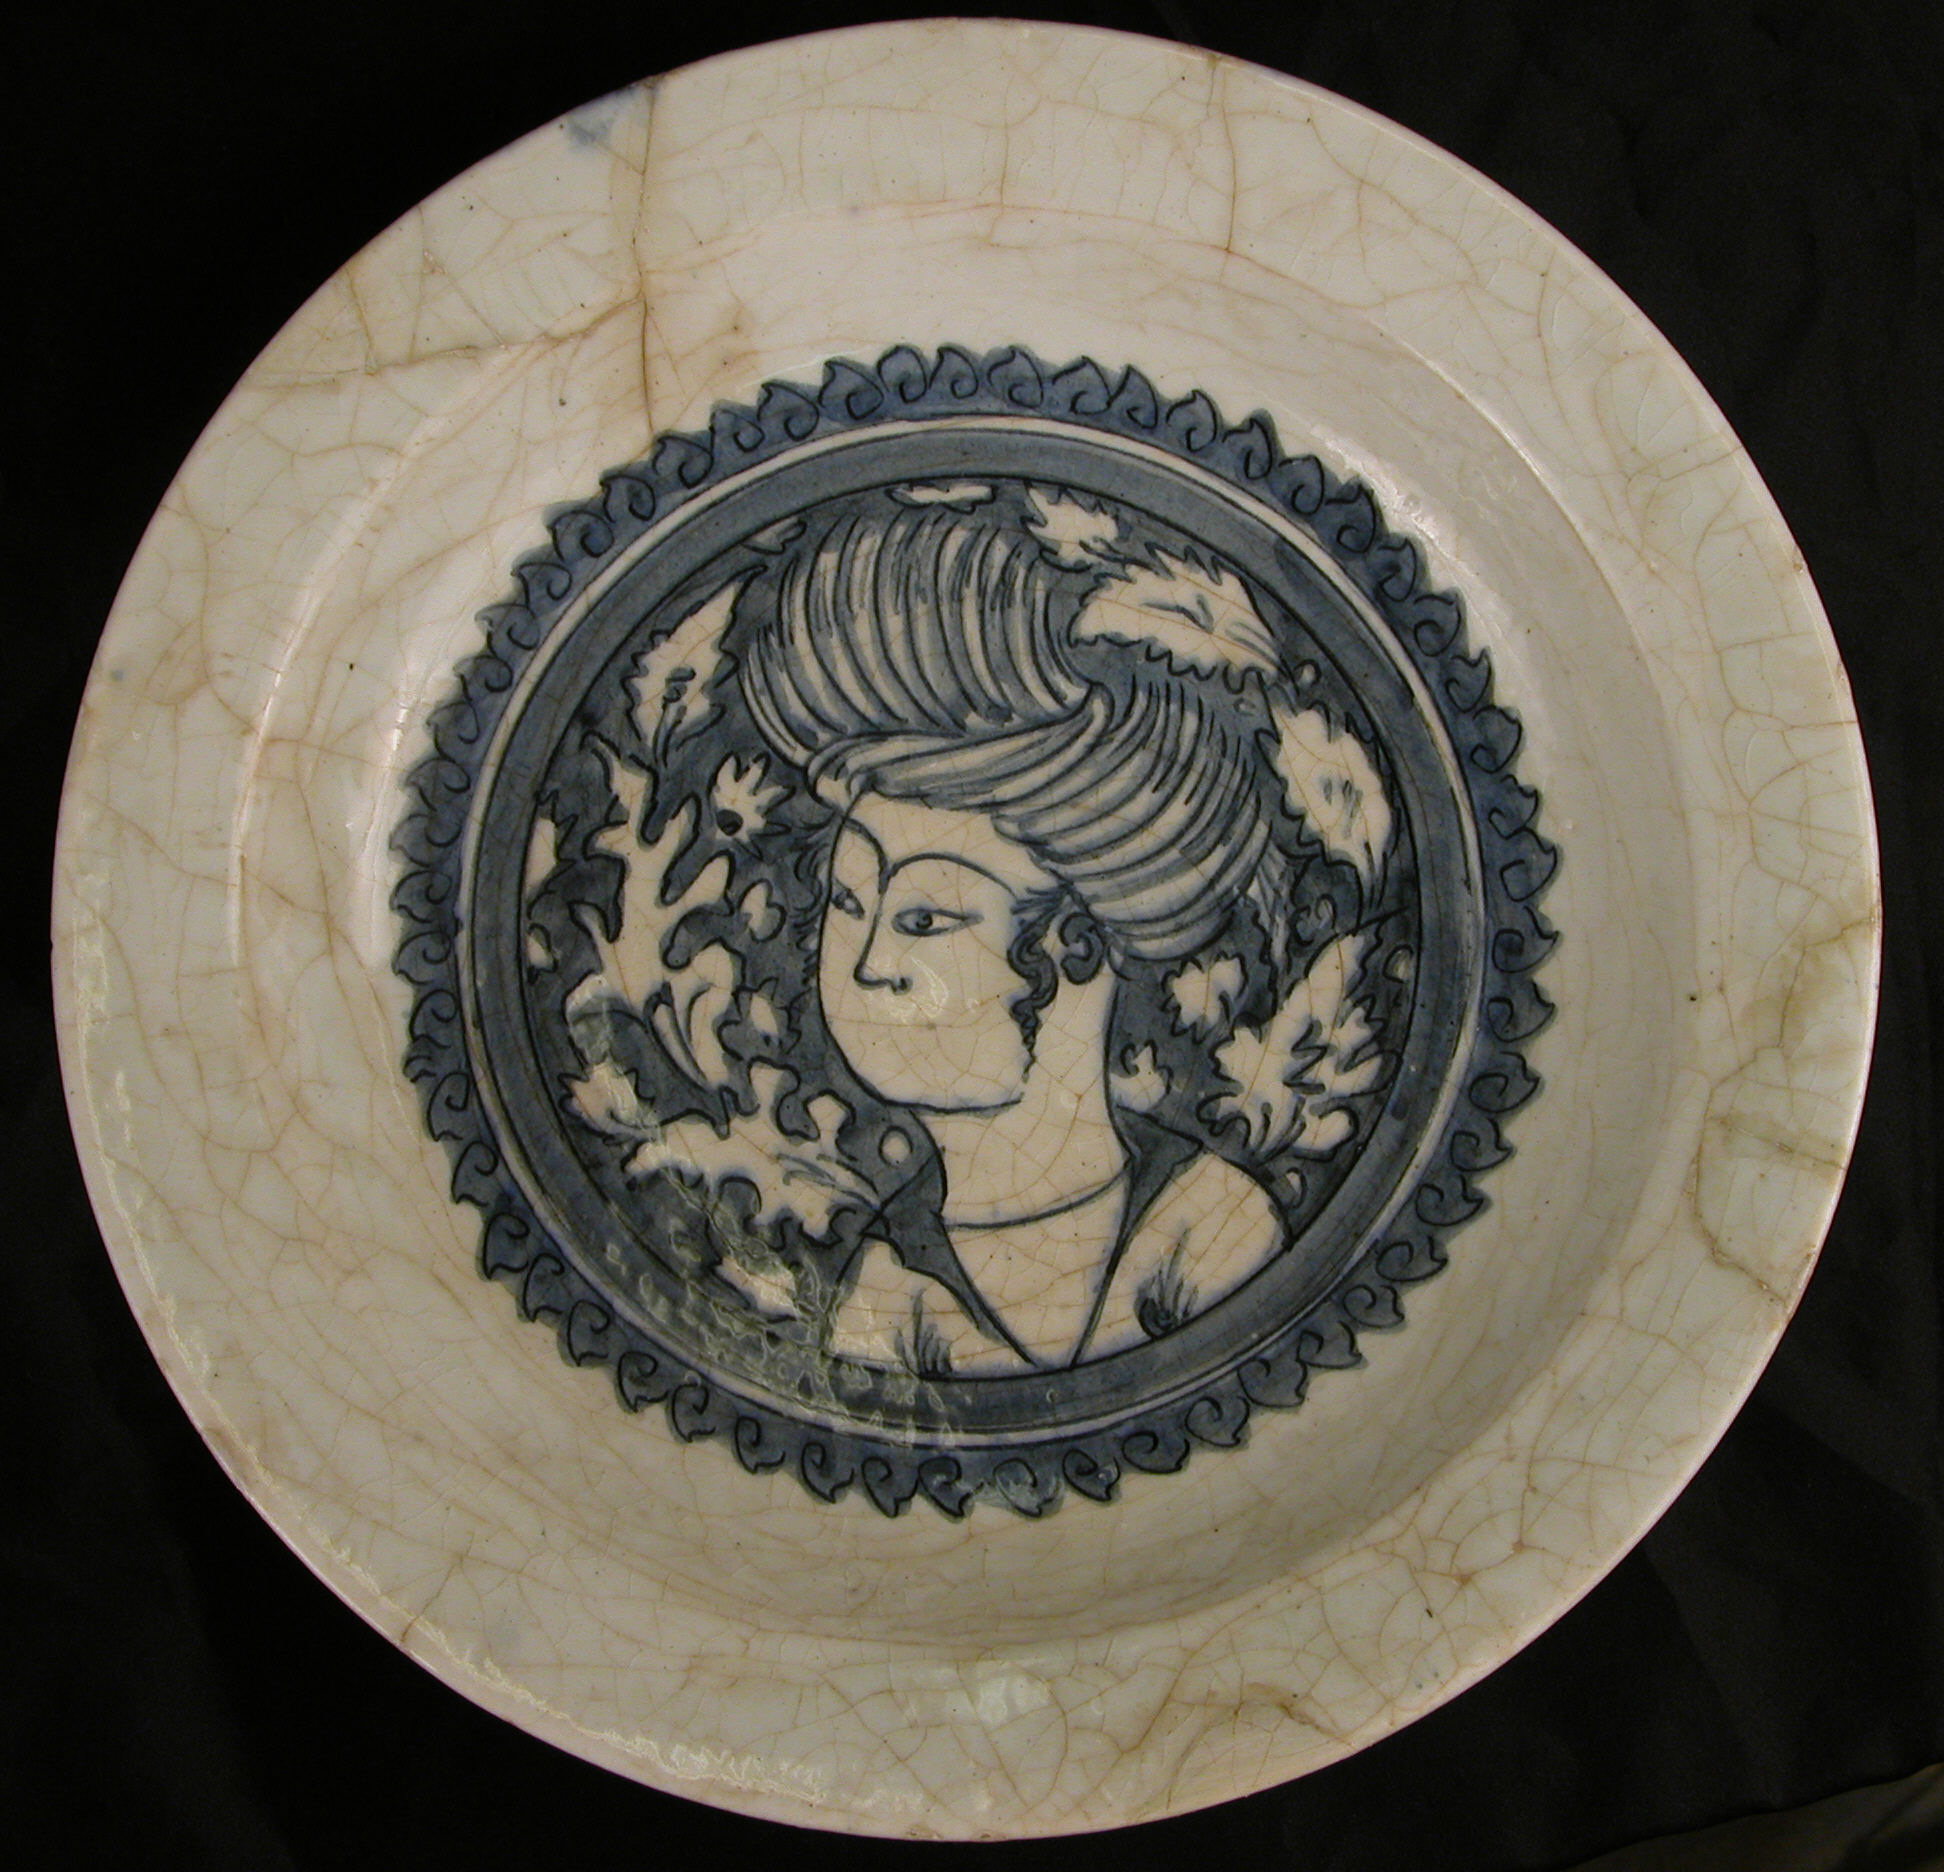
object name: dish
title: Dish with a Portrait of a Man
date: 1601-1700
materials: glaze, stonepaste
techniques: painting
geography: northwestern iran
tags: men